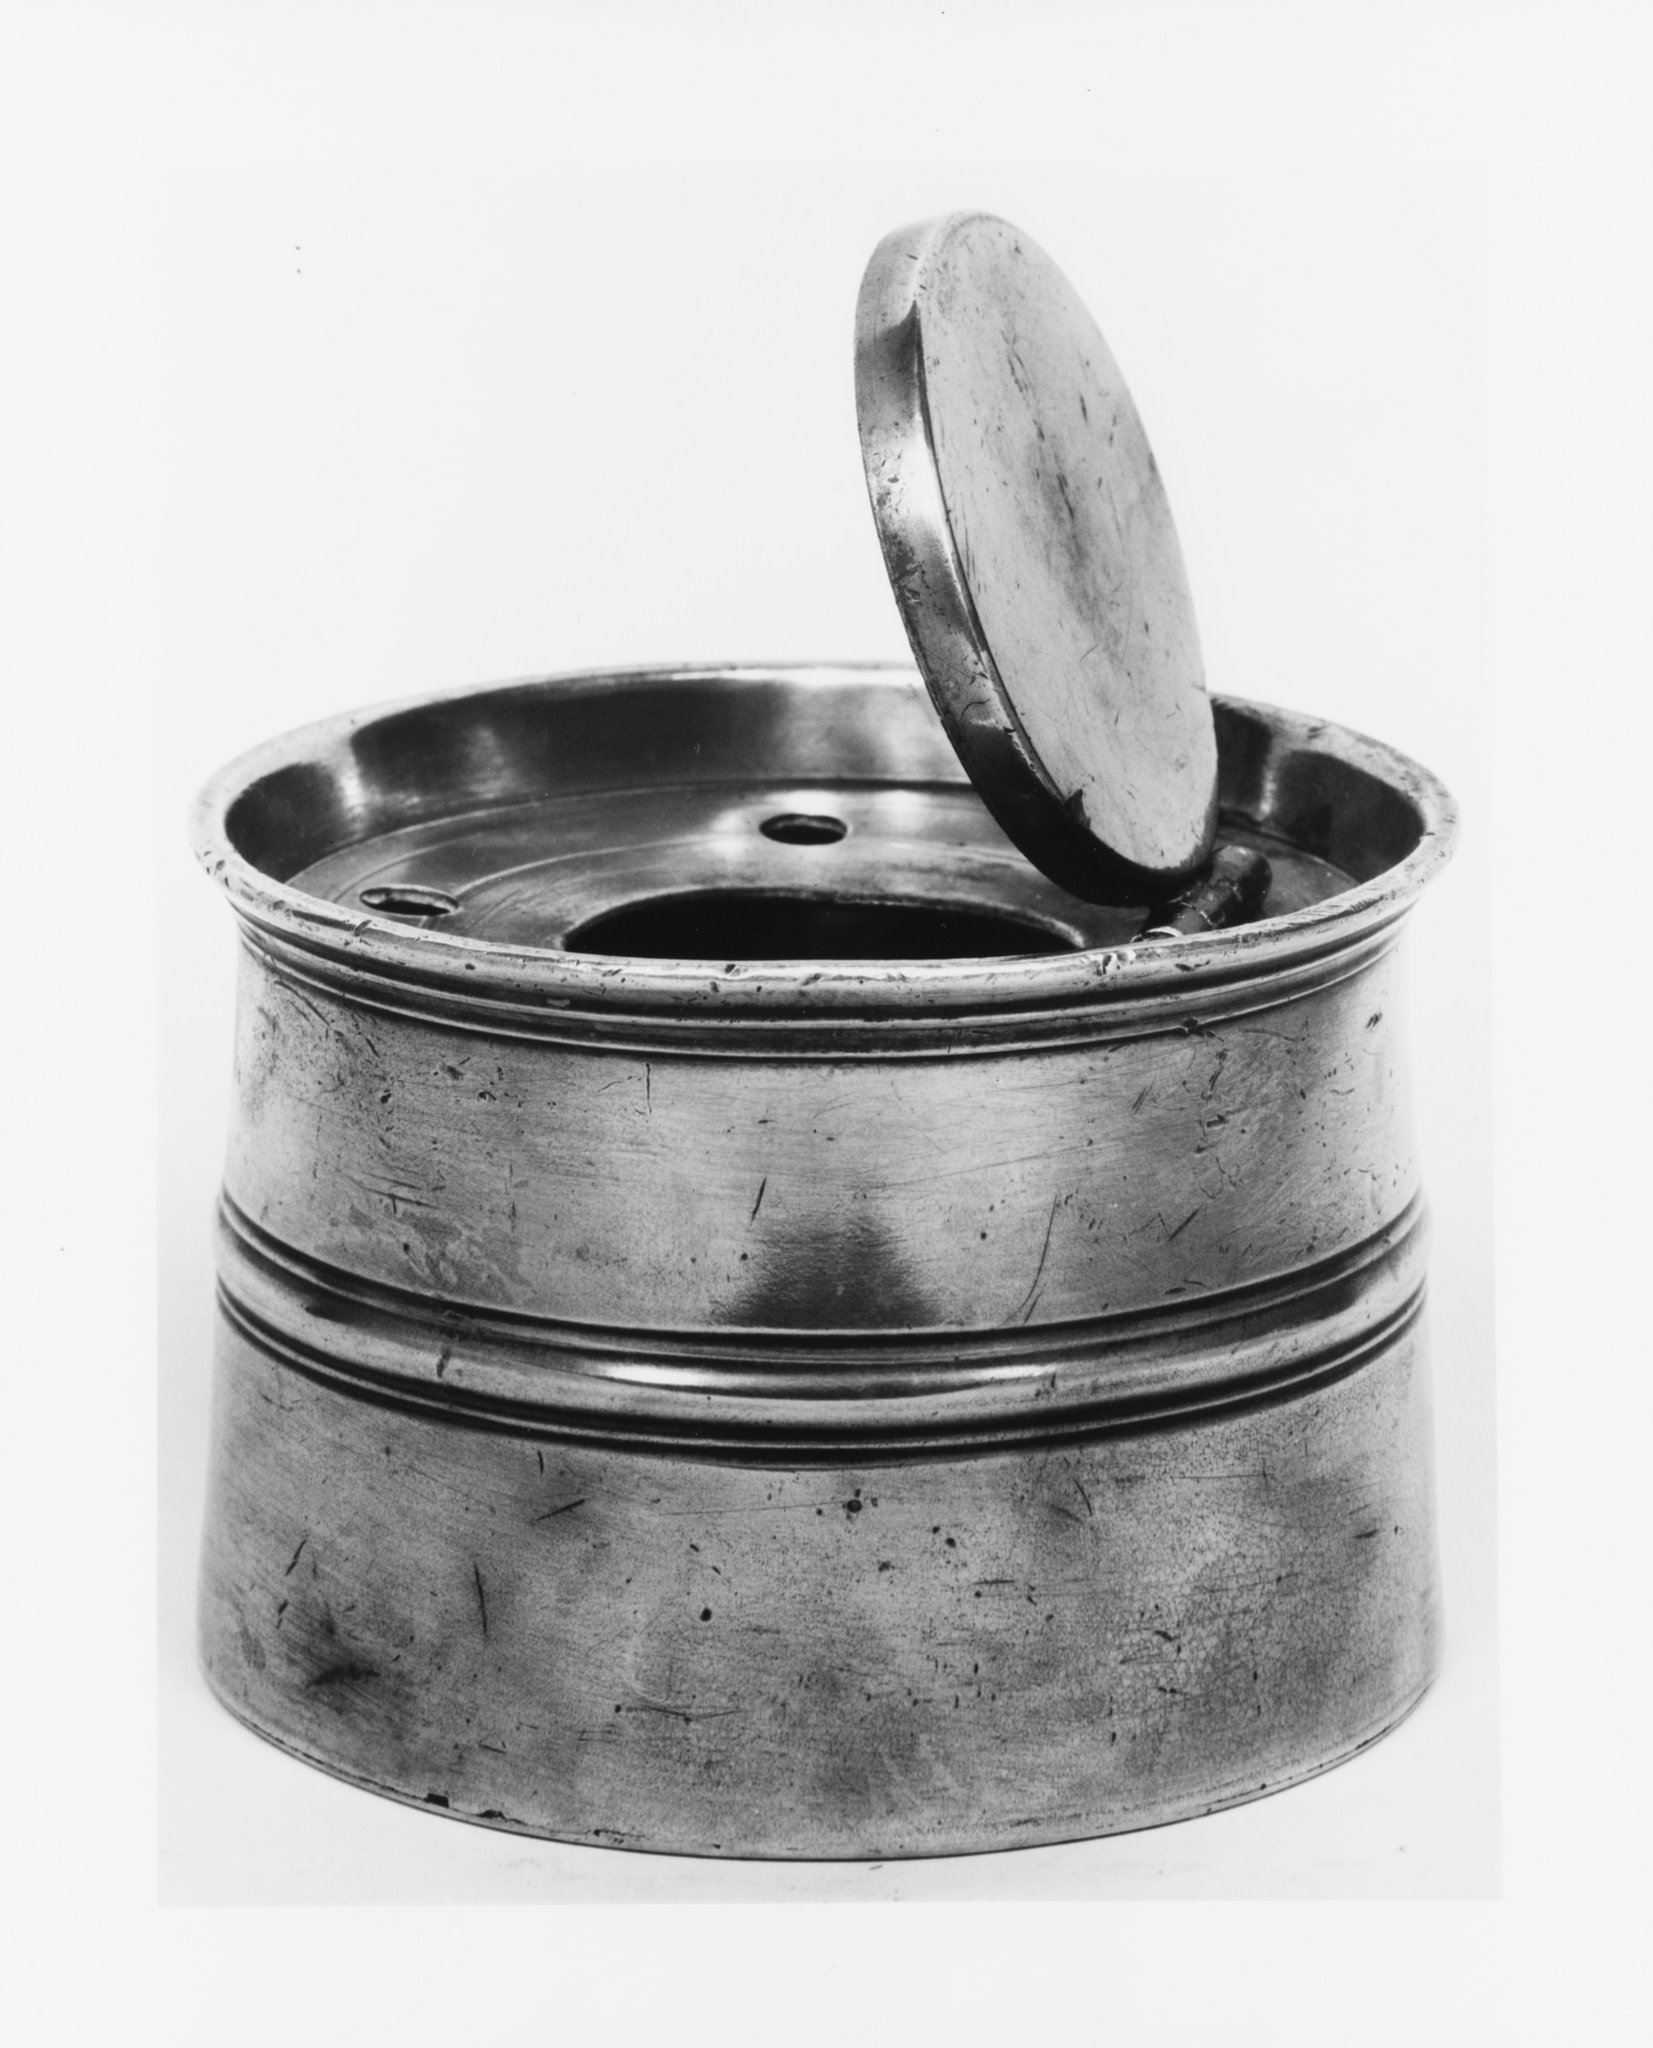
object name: inkwell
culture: american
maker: thomas danforth boardman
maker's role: maker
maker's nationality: american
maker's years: 1784-1873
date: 1810-1850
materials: pewter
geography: united states